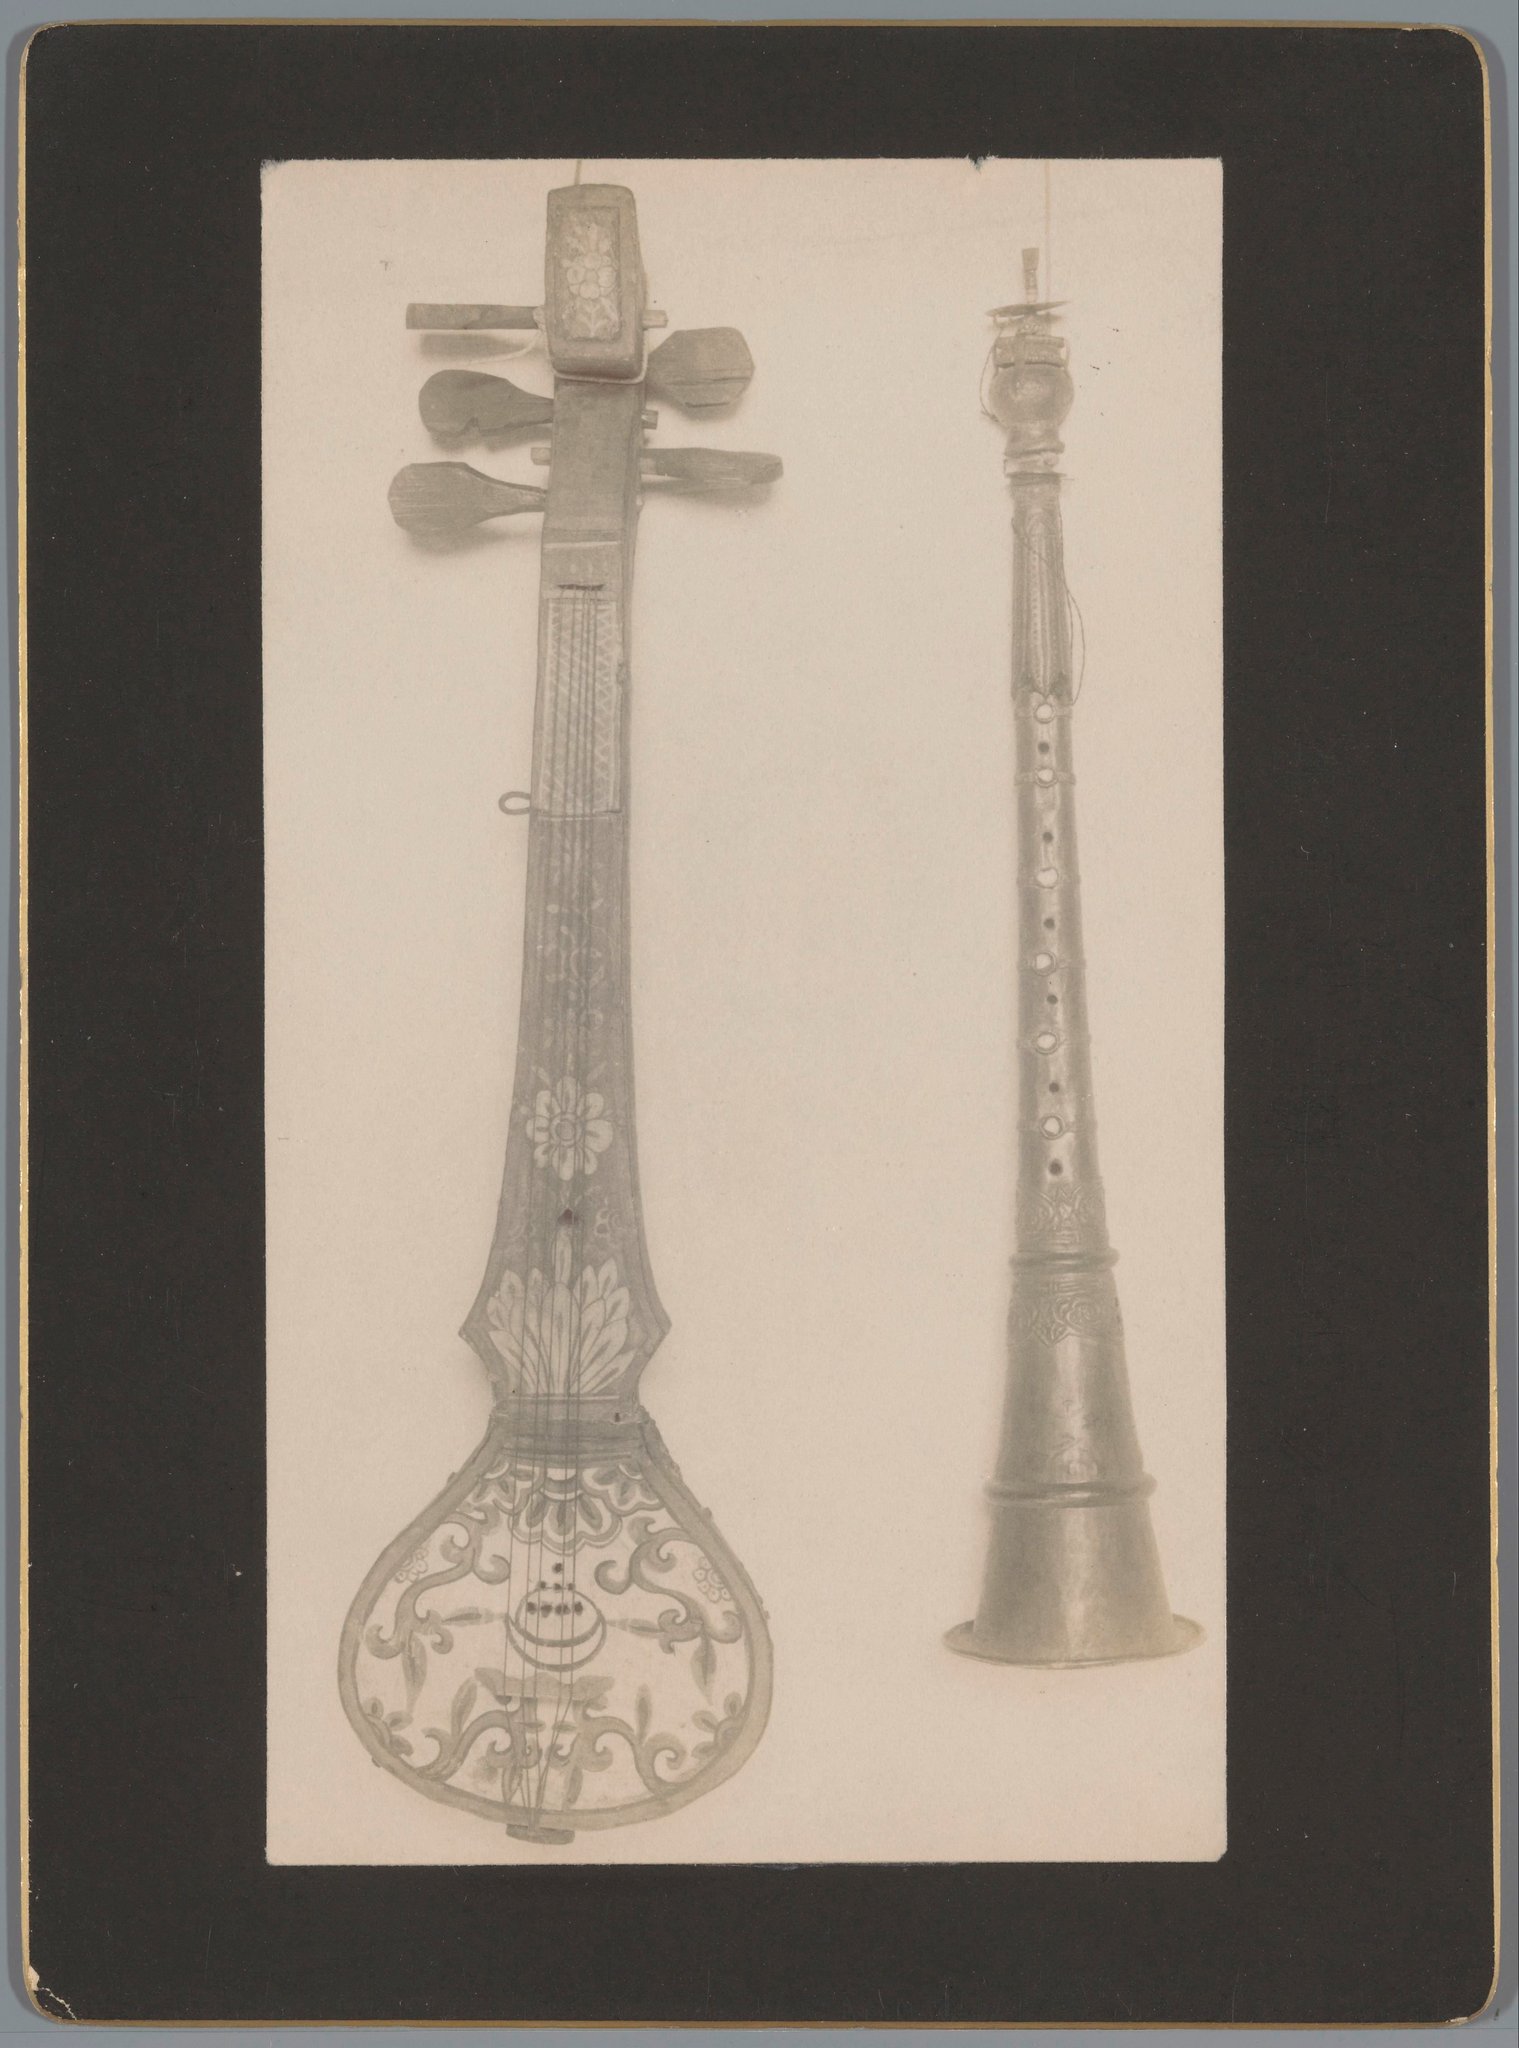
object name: photograph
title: Rijks Ethnographisch Museum Serie 1119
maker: Anonymous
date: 1890-1910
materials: cardboard, paper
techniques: albumen print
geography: rijks ethnographisch museum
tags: musical instruments; group of musical instruments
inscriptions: inscription: ‘Rijks Ethnographisch Museum/ Serie 1119/ No 28/ Koperen/ trompet met/ [...] versierd/ No 27/ Guitaar/ Thibet’